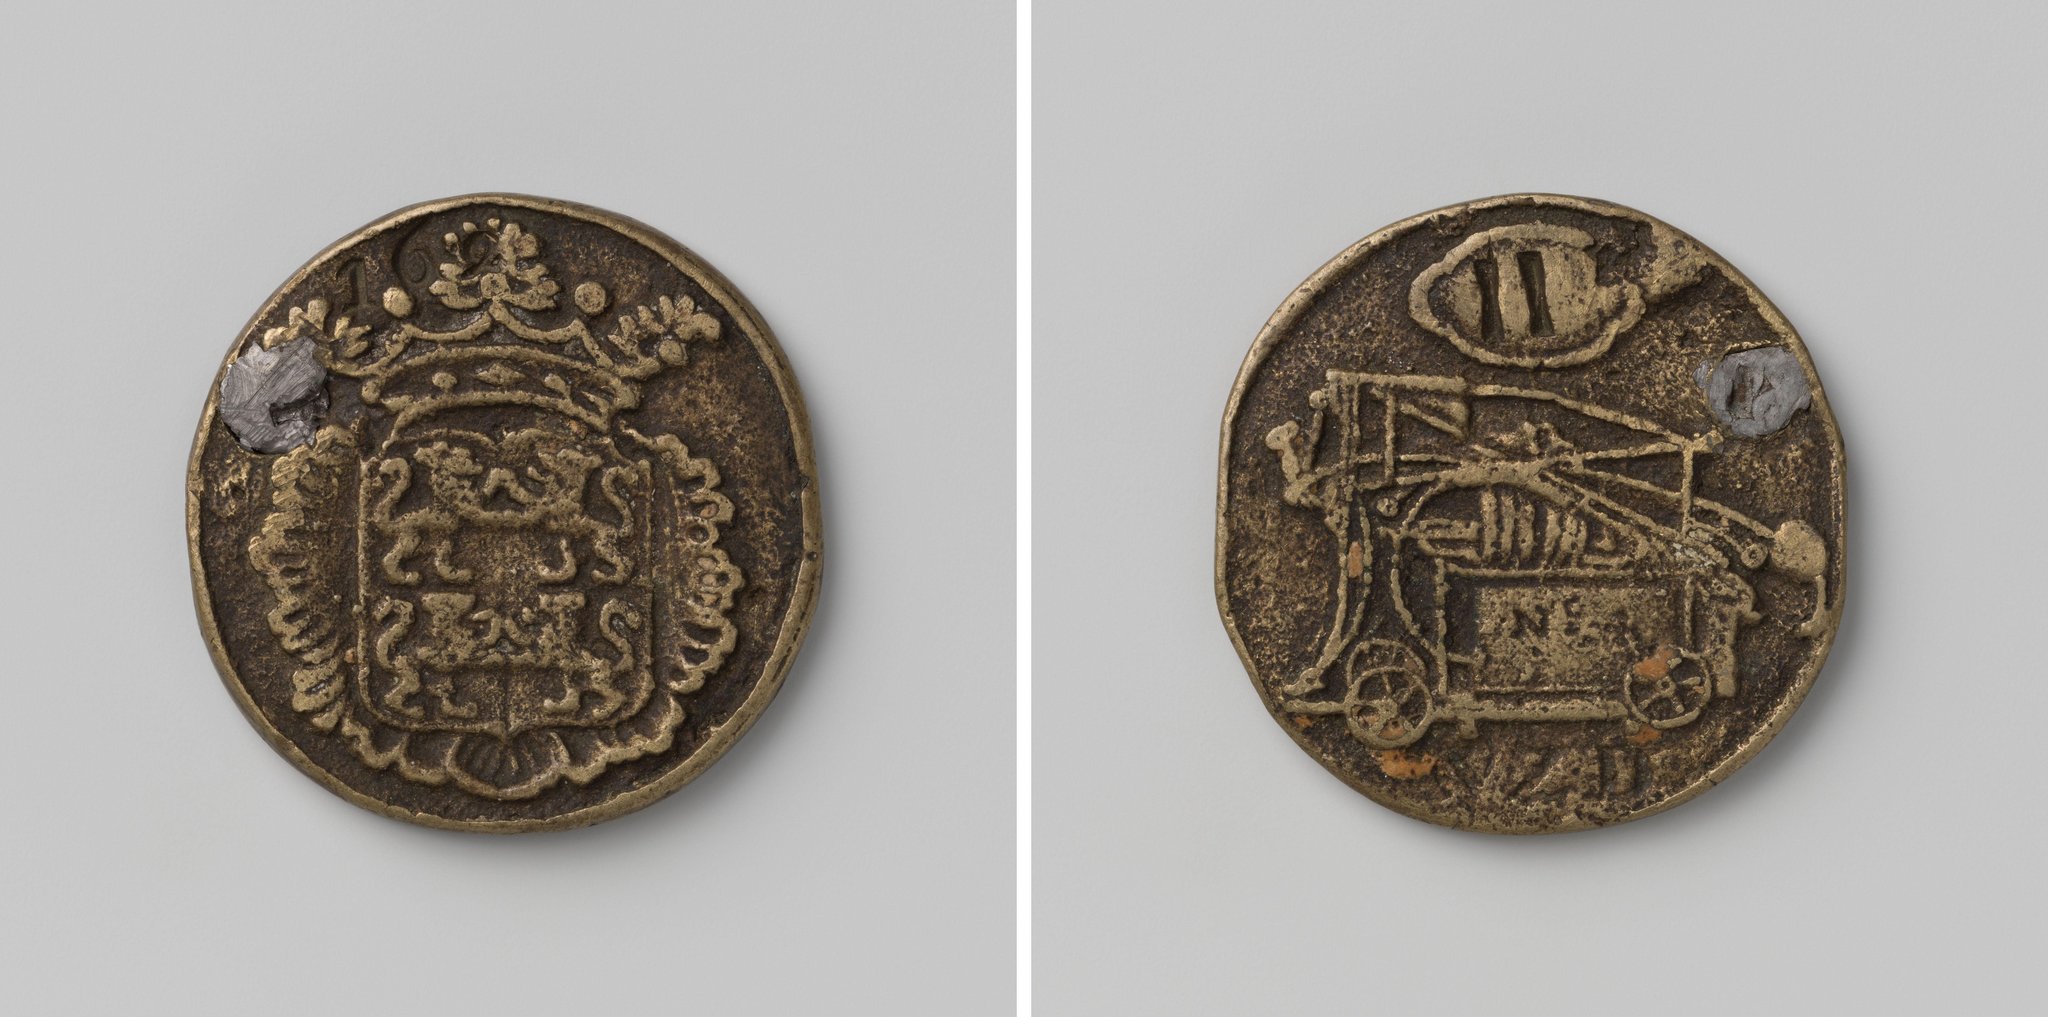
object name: medal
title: Schoonhoven, brandspuitpenning van spuit 4 met no. 162, no. 11 en W.Z.D.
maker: Anonymous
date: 1680-1800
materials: brass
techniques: casting, engraving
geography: schoonhoven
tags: schoonhoven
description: Messing penning met gat erin, dicht gemaakt met ander soort metaal. Voorzijde: gekroond wapenschild in cartouche onder cijfer 162. Keerzijde: rijdende brandspuit boven opschrift W.Z.D. en cartouche met cijfer 11; op zijde van brandspuit: cijfer 4